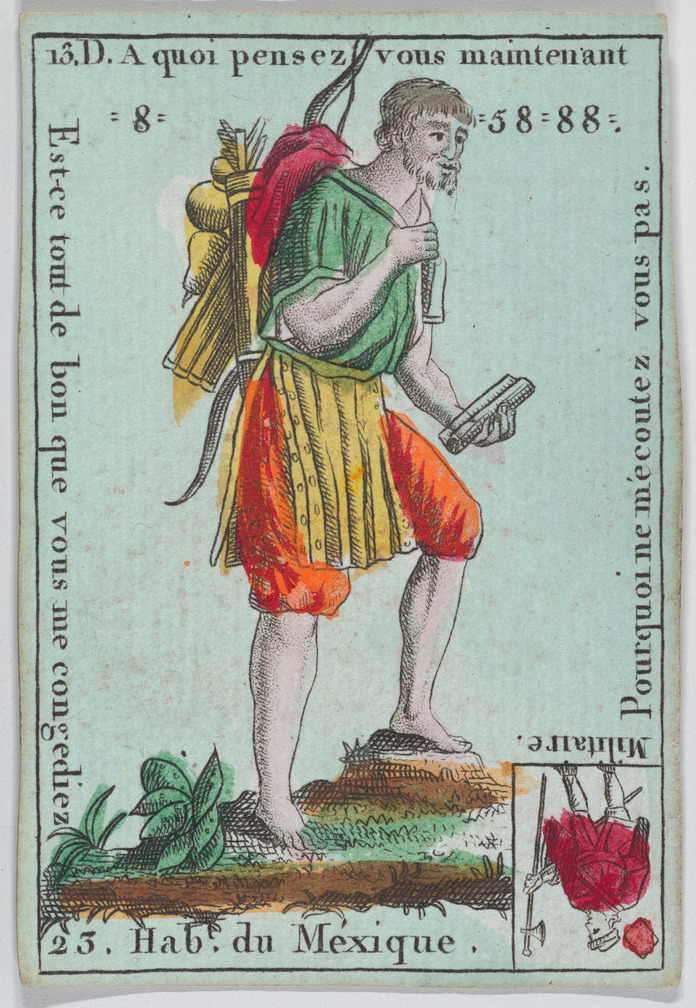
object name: print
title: Hab.t du Méxique from playing cards "Jeu d'Or"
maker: anonymous, french, 18th century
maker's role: artist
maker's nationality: french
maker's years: 1700-1800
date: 1700-1799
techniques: etching, hand coloring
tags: bow and arrow,men,portraits,playing cards